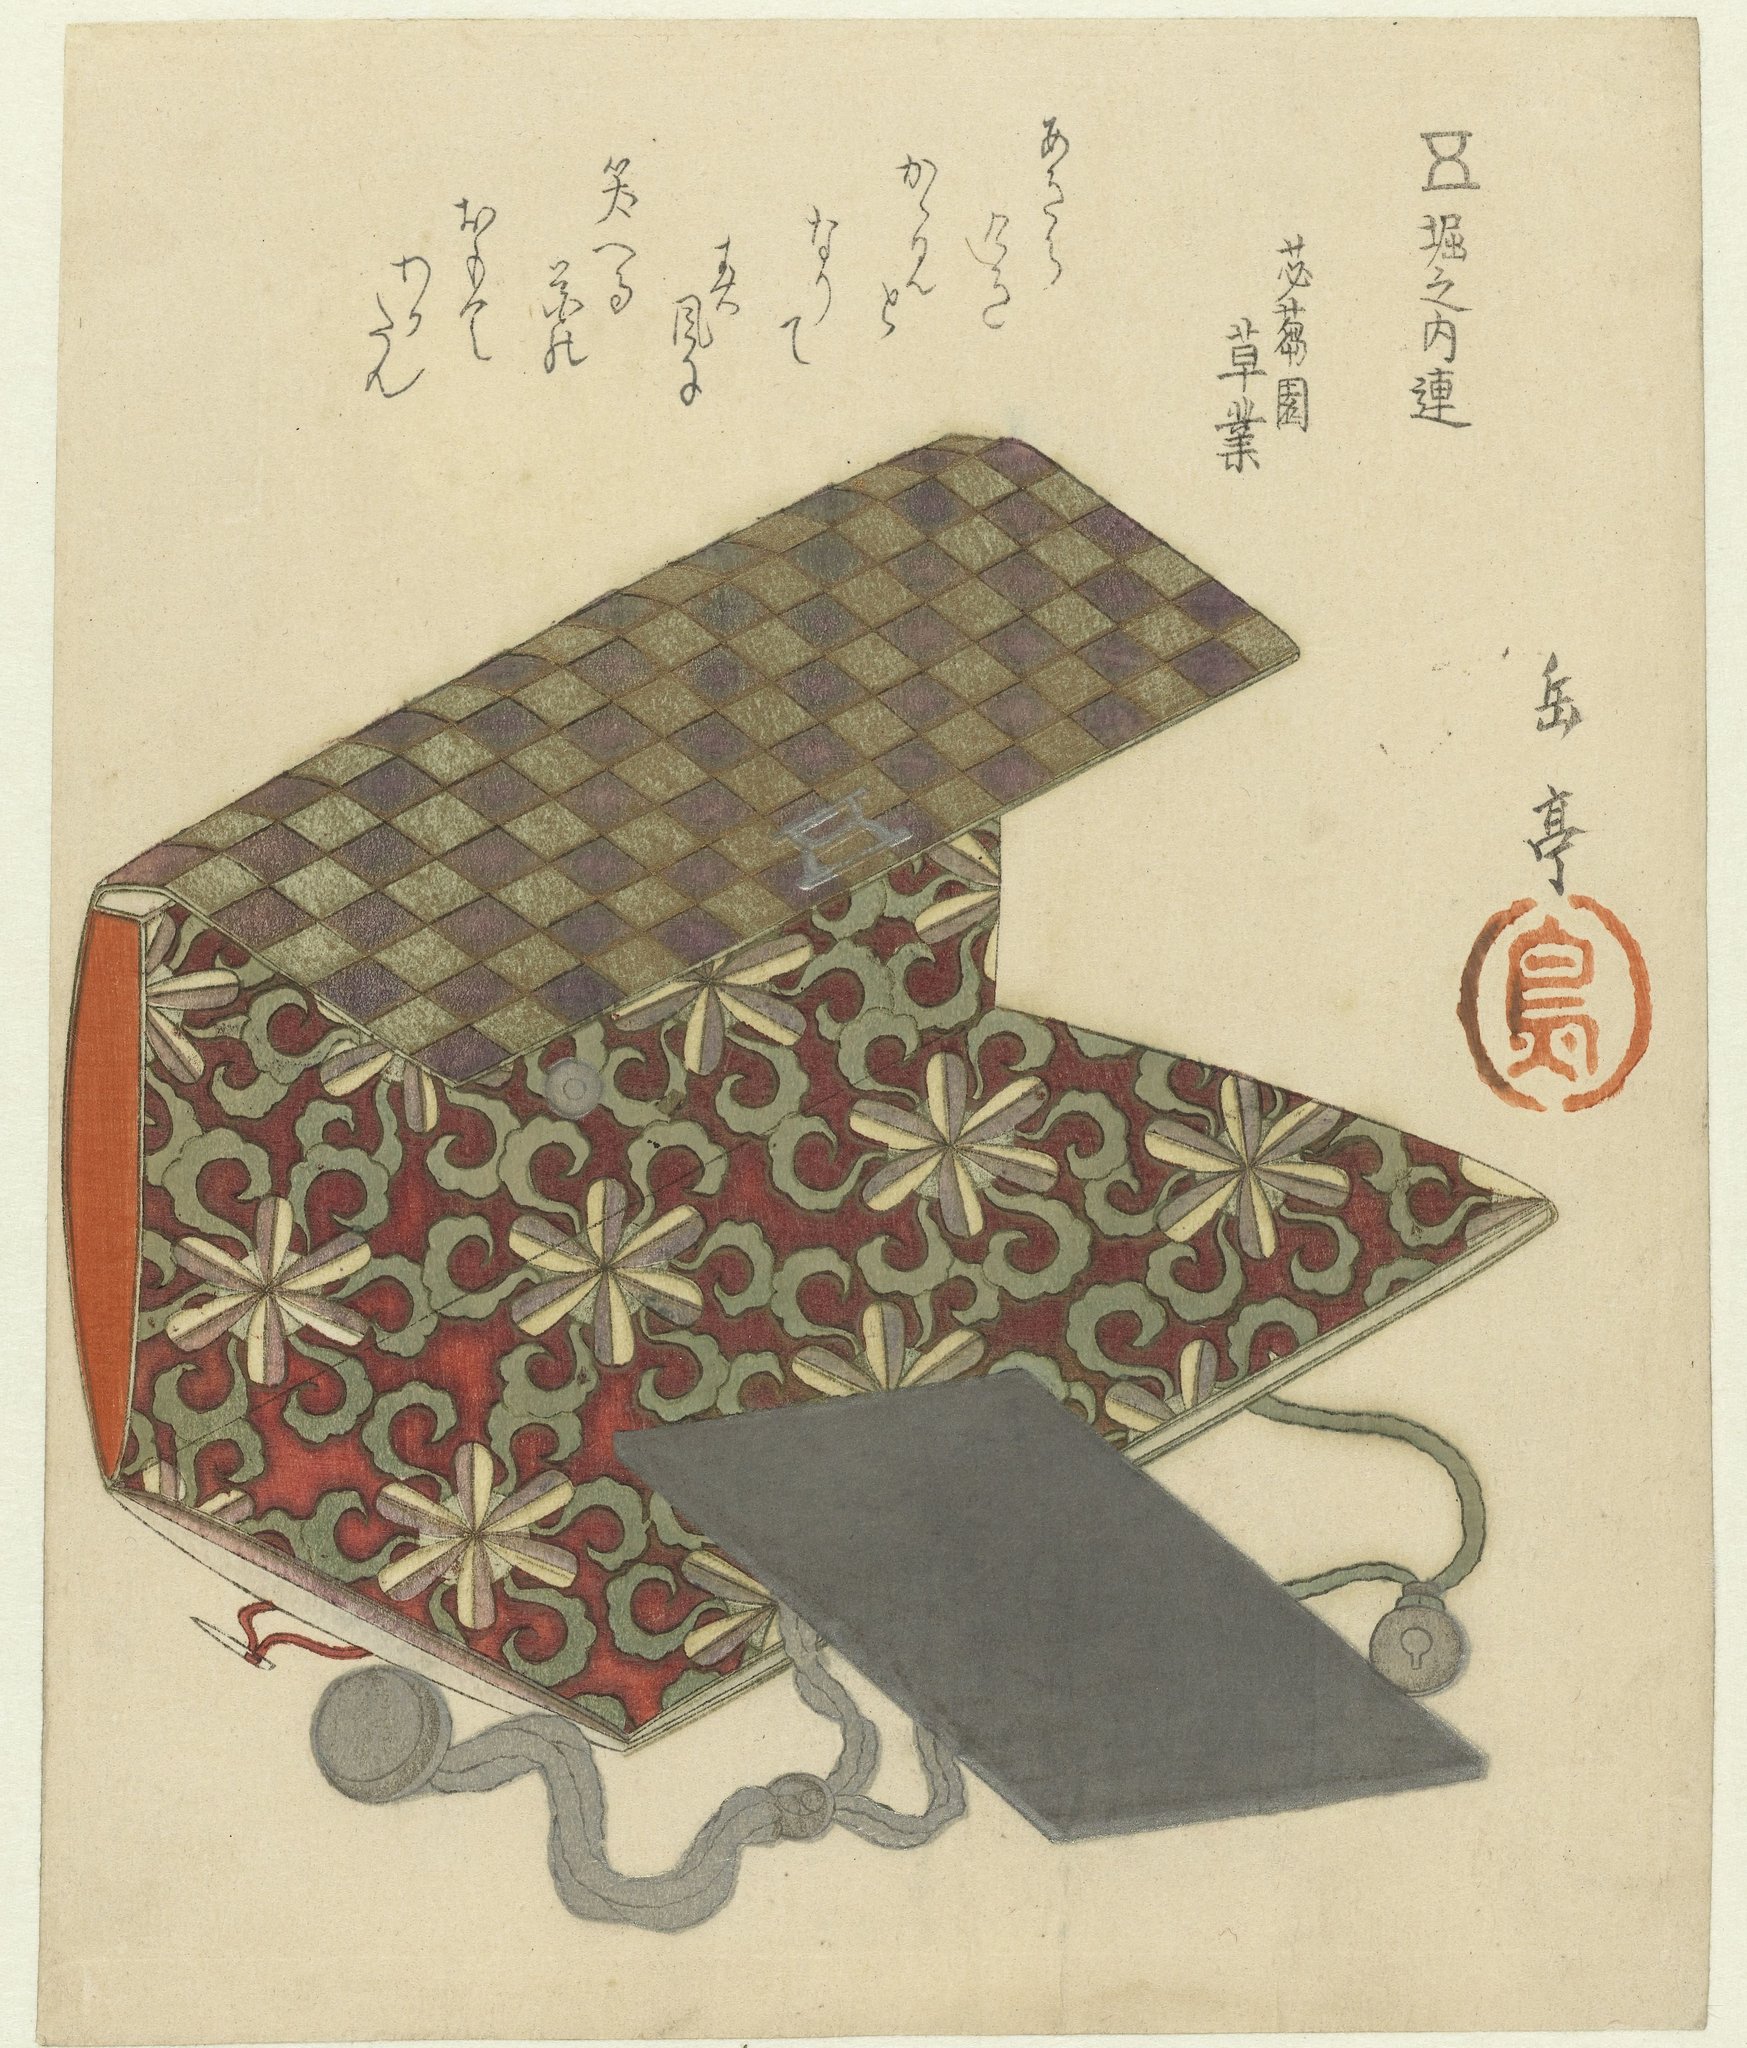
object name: surimono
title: Pouch and Mirror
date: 1825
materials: paper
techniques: blind stamped, woodcut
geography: japan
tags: mirror writing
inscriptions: collector's mark, passe-partout, bottom left, printed: JABdH with a rooster., collector's mark, verso, stamped: Lugt 2228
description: Een surimono is een luxe uitgevoerde prent waarop beeld met één of meerdere gedichten gecombineerd is. Bij het drukken van een surimono werd vaak gebruik gemaakt van dikker papier, blinddruk en metaal pigmenten, zoals koper- en zilverpoeder. De prenten werden vaak in opdracht van dichters gemaakt en als exclusief geschenk aan vrienden en relaties gegeven.